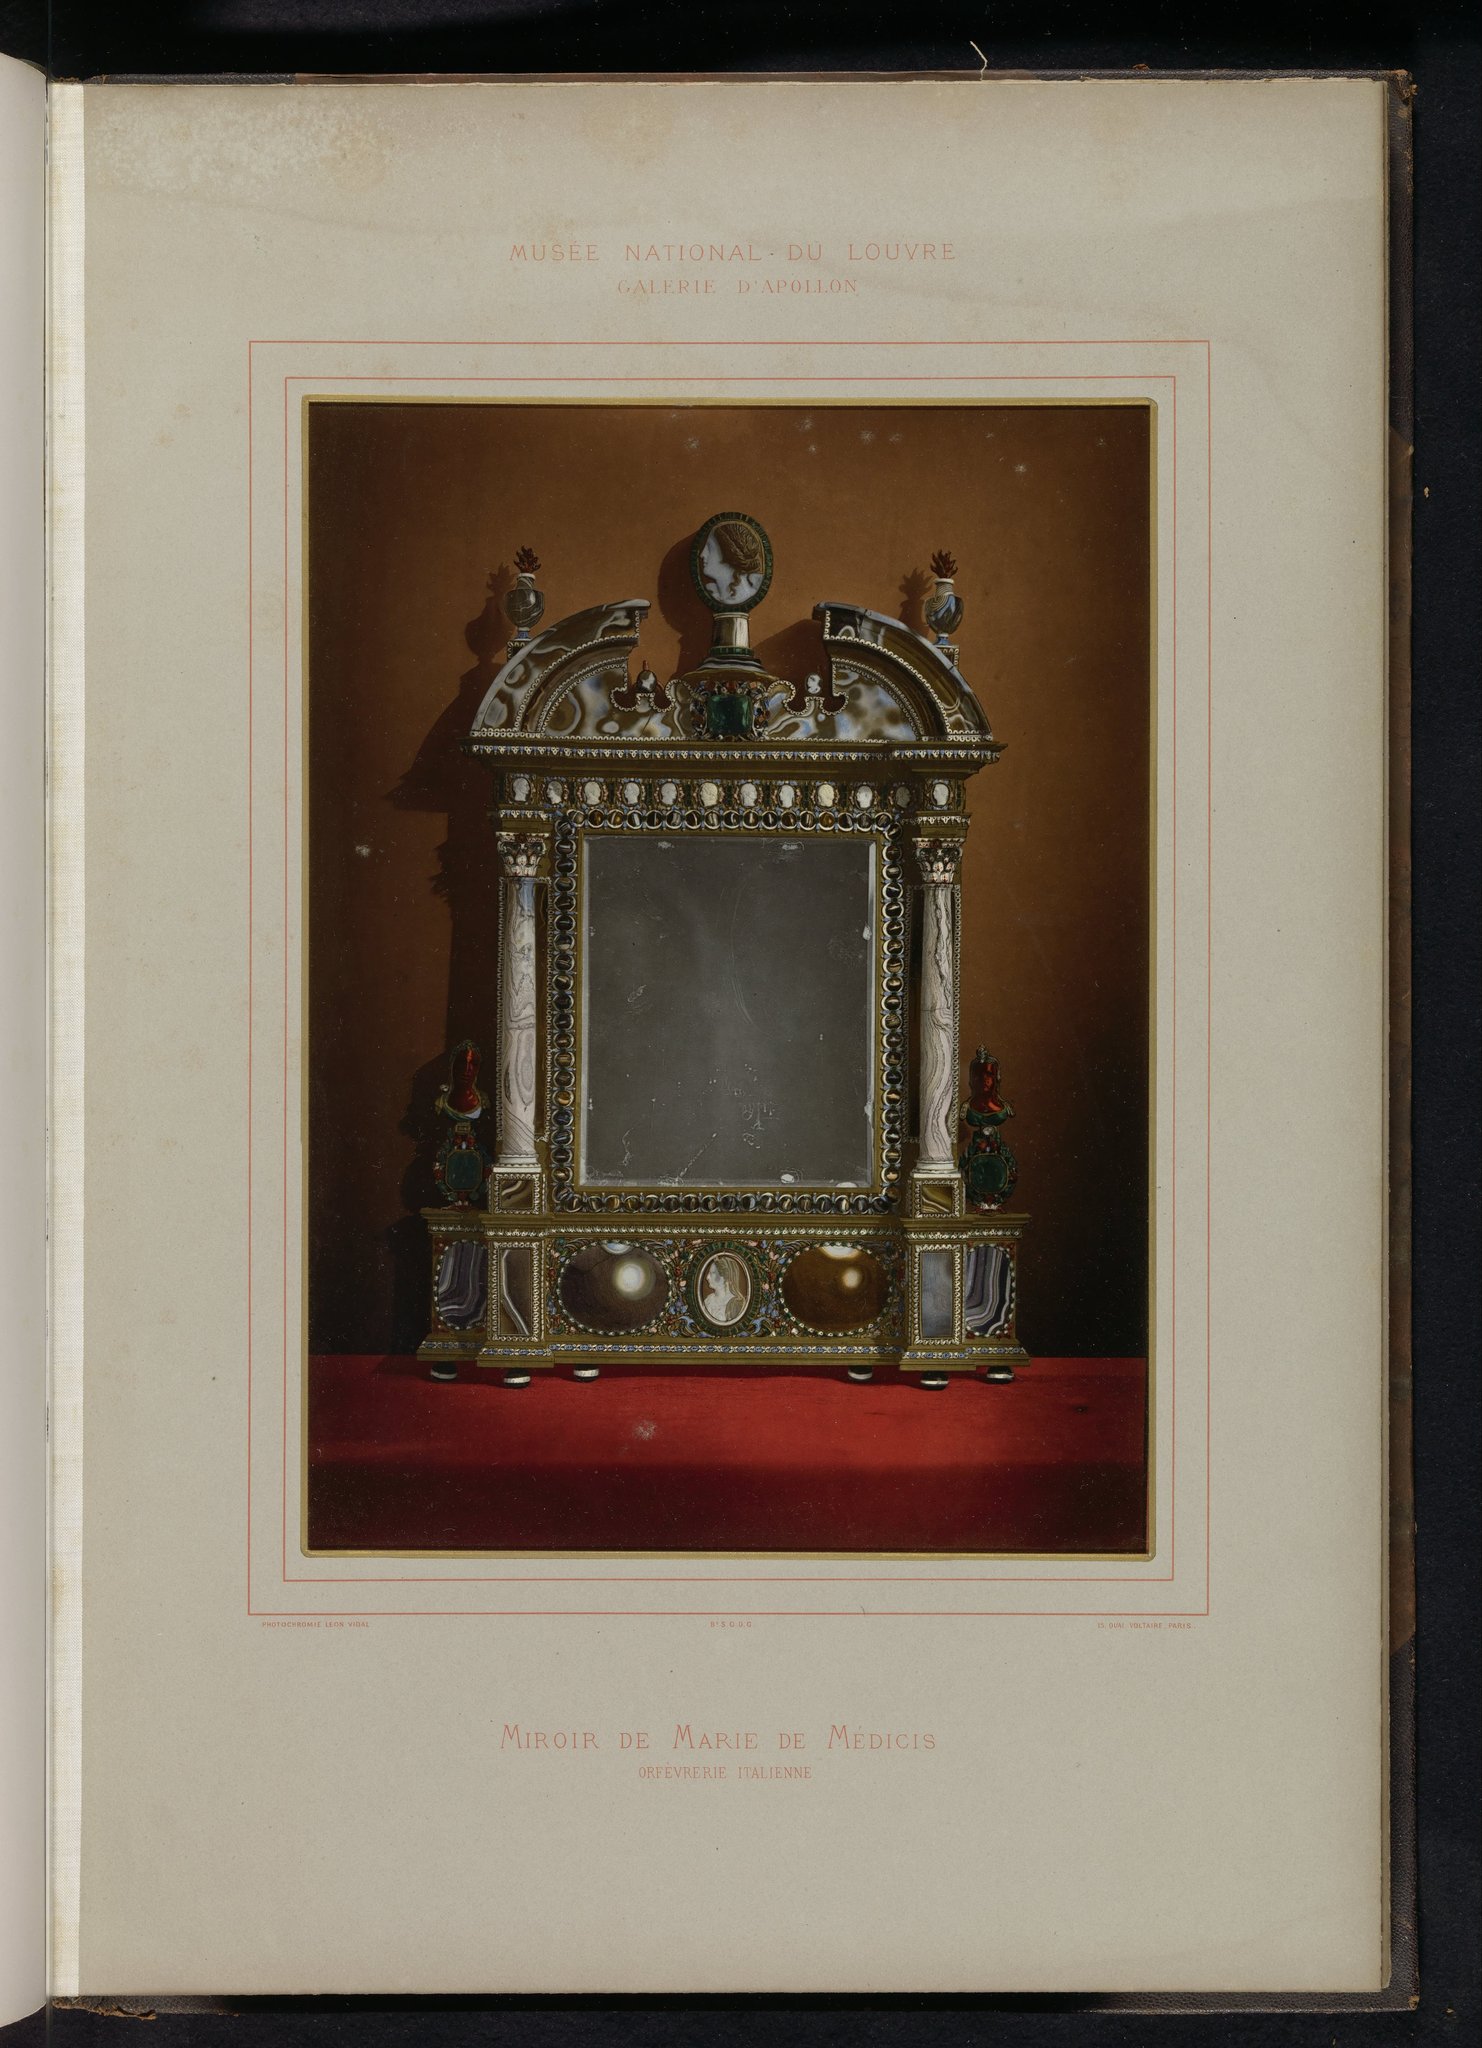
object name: photomechanical print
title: Spiegel van Maria de' Medici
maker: léon vidal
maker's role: fotograaf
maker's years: 1833-1906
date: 1876-1883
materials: paper, photographic process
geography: paris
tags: mirror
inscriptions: inscription: ‘Musée National du Louvre Galerie d'Apollon’, inscription: ‘15 Quai Voltaire. Paris.’, inscription: ‘9e livraison’